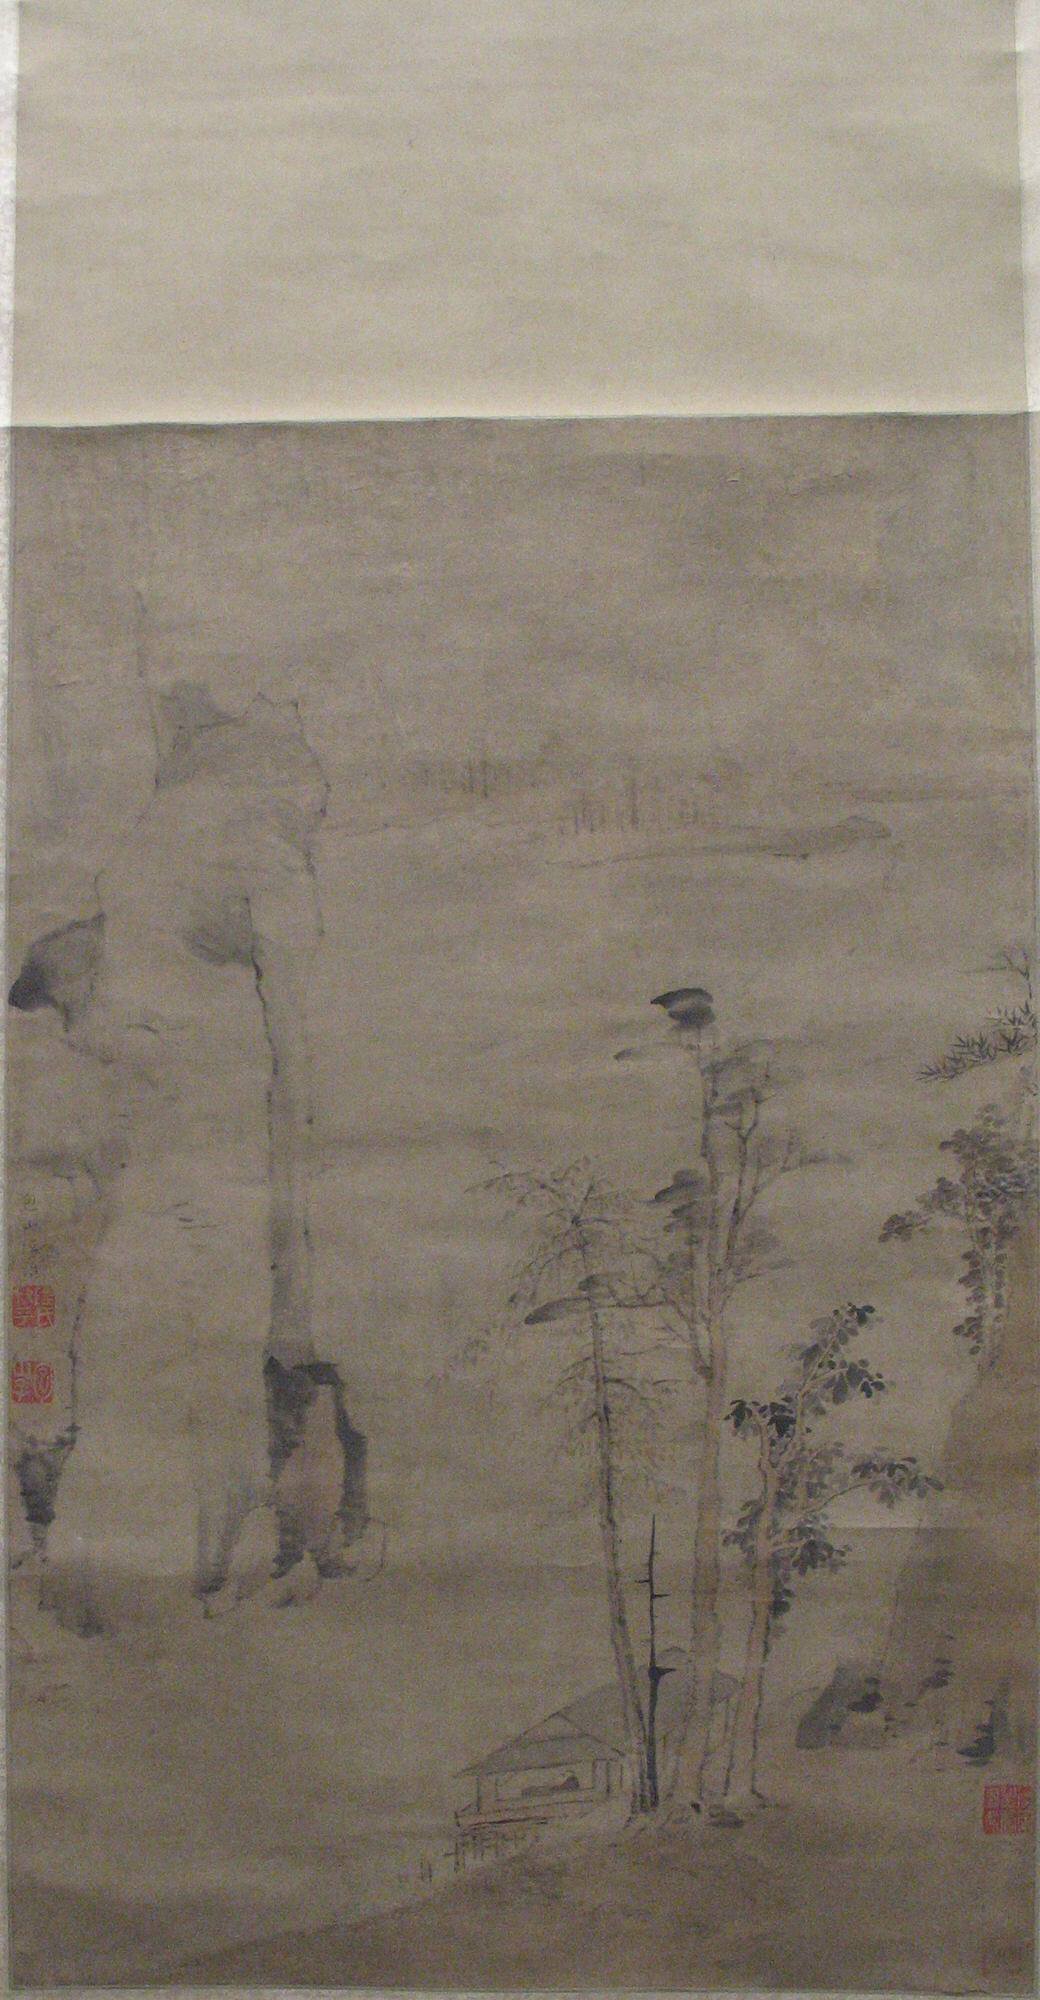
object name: hanging scroll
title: An Autumnal Grove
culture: chinese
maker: unidentified artist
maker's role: artist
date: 1368-1911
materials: ink, paper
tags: trees